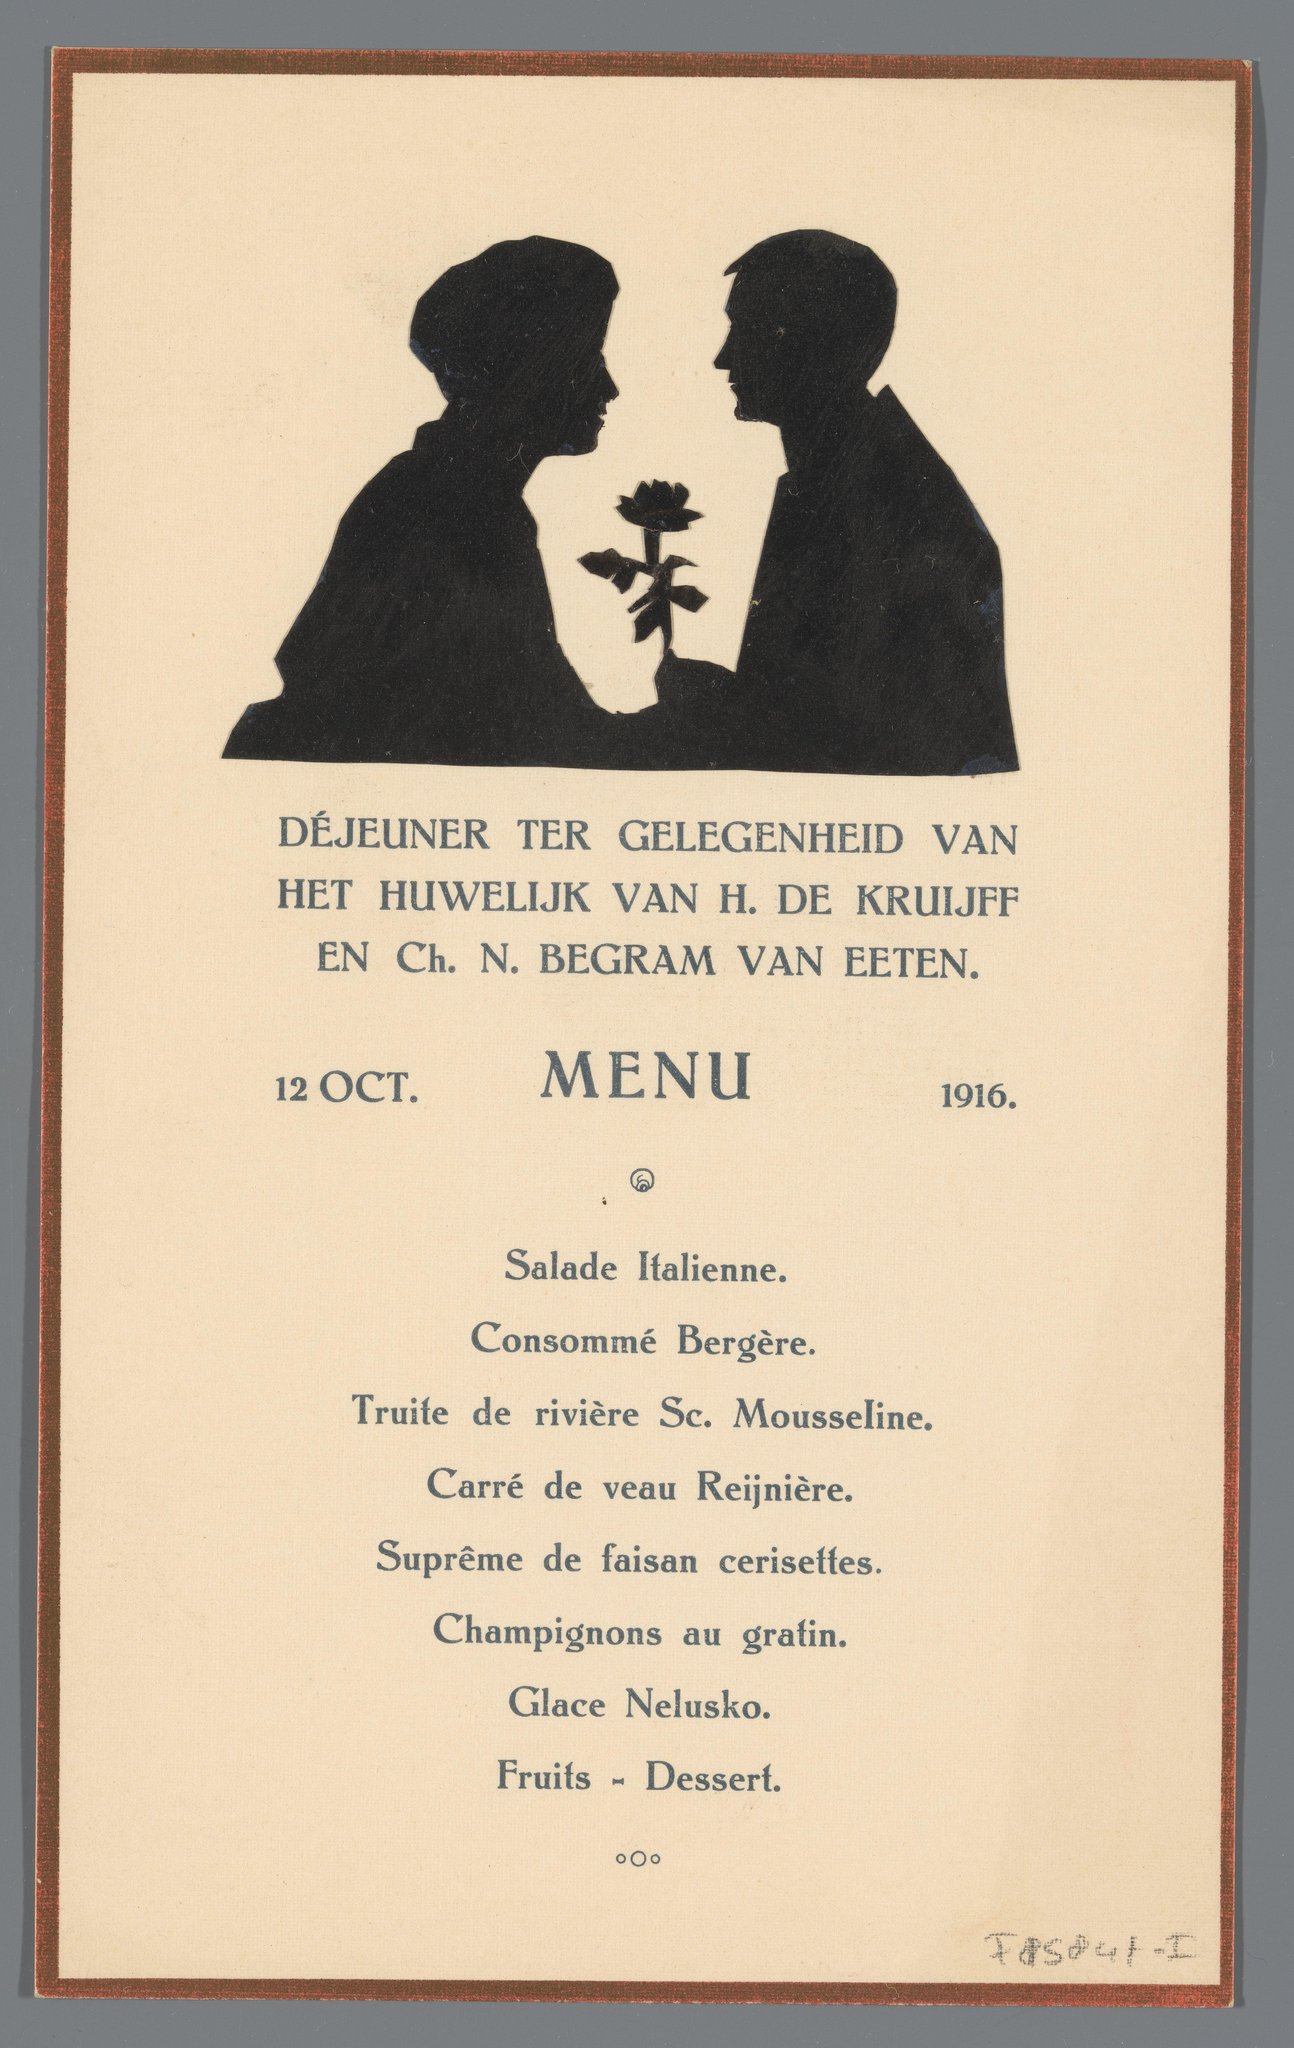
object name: menu, menukaart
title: Menukaart van de lunch ter ere van het huwelijk tussen H. de Kruijff en Ch. N. Begram van Eeten, met silhouetportret van het paar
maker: Anonymous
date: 1916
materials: paper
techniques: letterpress printing, snipping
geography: netherlands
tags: amsterdam, engineer, historical persons, couple of lovers, zeist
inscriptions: inscription: ‘Déjeuner ter gelegenheid van/ het huwelijk van H. de Kruijff/ en Ch. N. Begram van Eeten./ 12 Oct. Menu 1916. (...)’